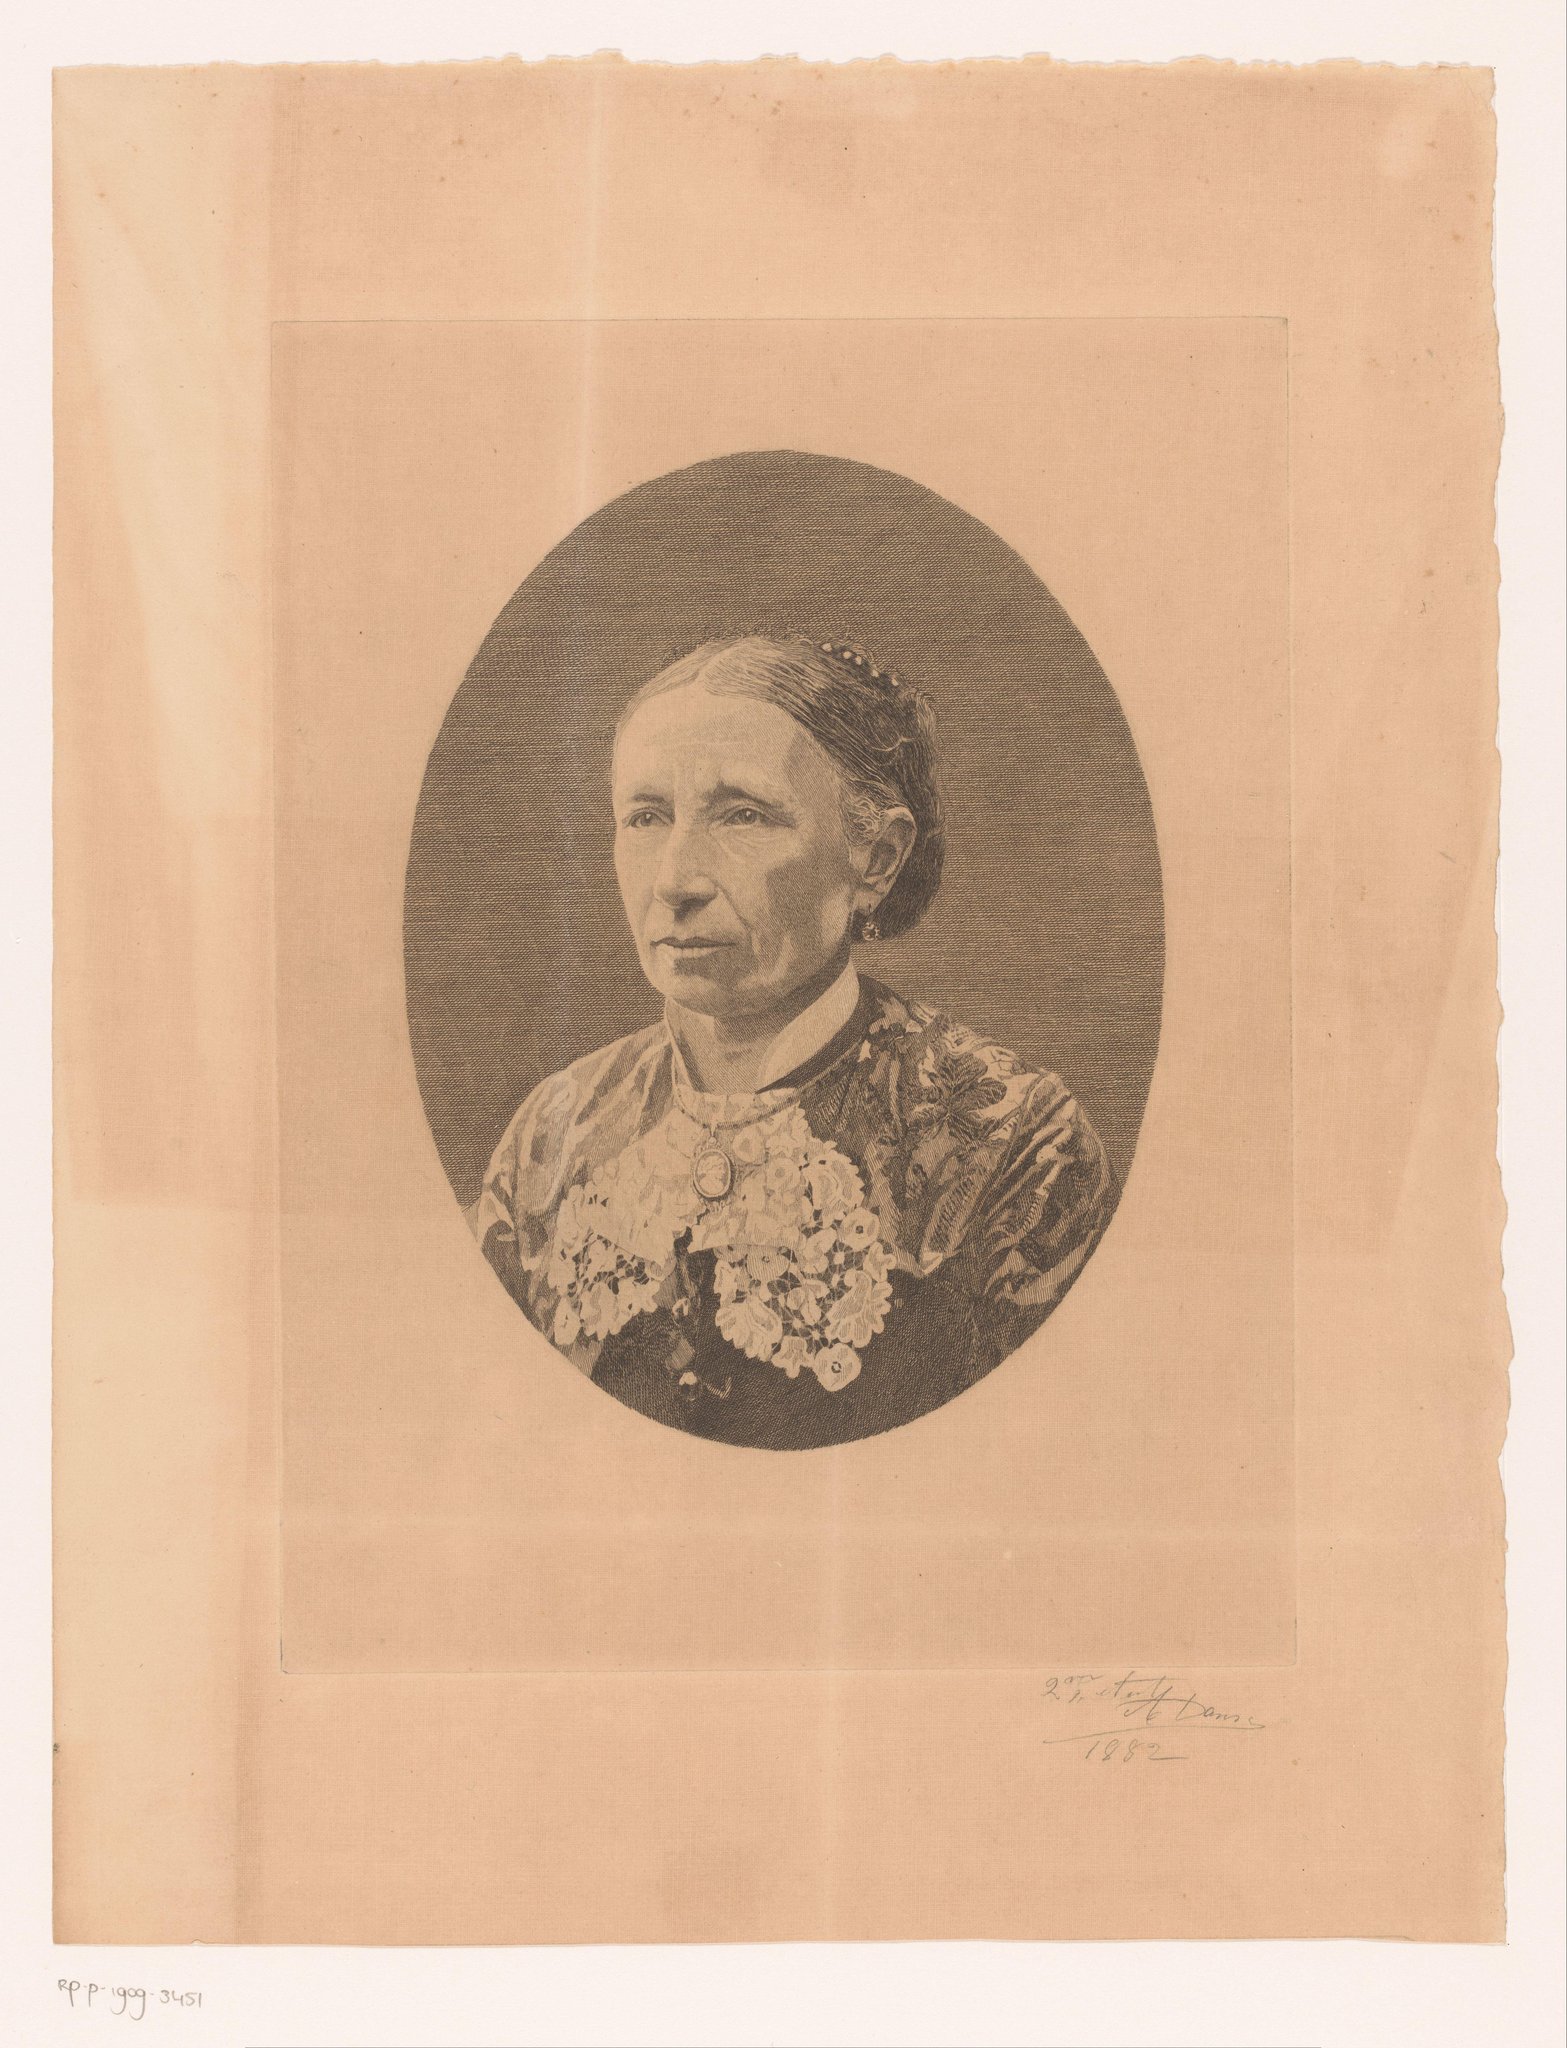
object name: print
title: Portret van een onbekende vrouw, mogelijk mevrouw Boulez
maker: auguste danse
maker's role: print maker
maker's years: 1829-1929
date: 1882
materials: paper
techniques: etching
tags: anonymous historical person portrayed alone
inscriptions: watermark: ‘Franse lelie in een wapenschild boven monogram VGZ’, annotation: ‘2me état’, collector's mark: Lugt 2228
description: De identificatie madame Boulez is gebaseerd op een handgeschreven annotatie op een ander exemplaar in de collectie van het Rijksmuseum Amsterdam.